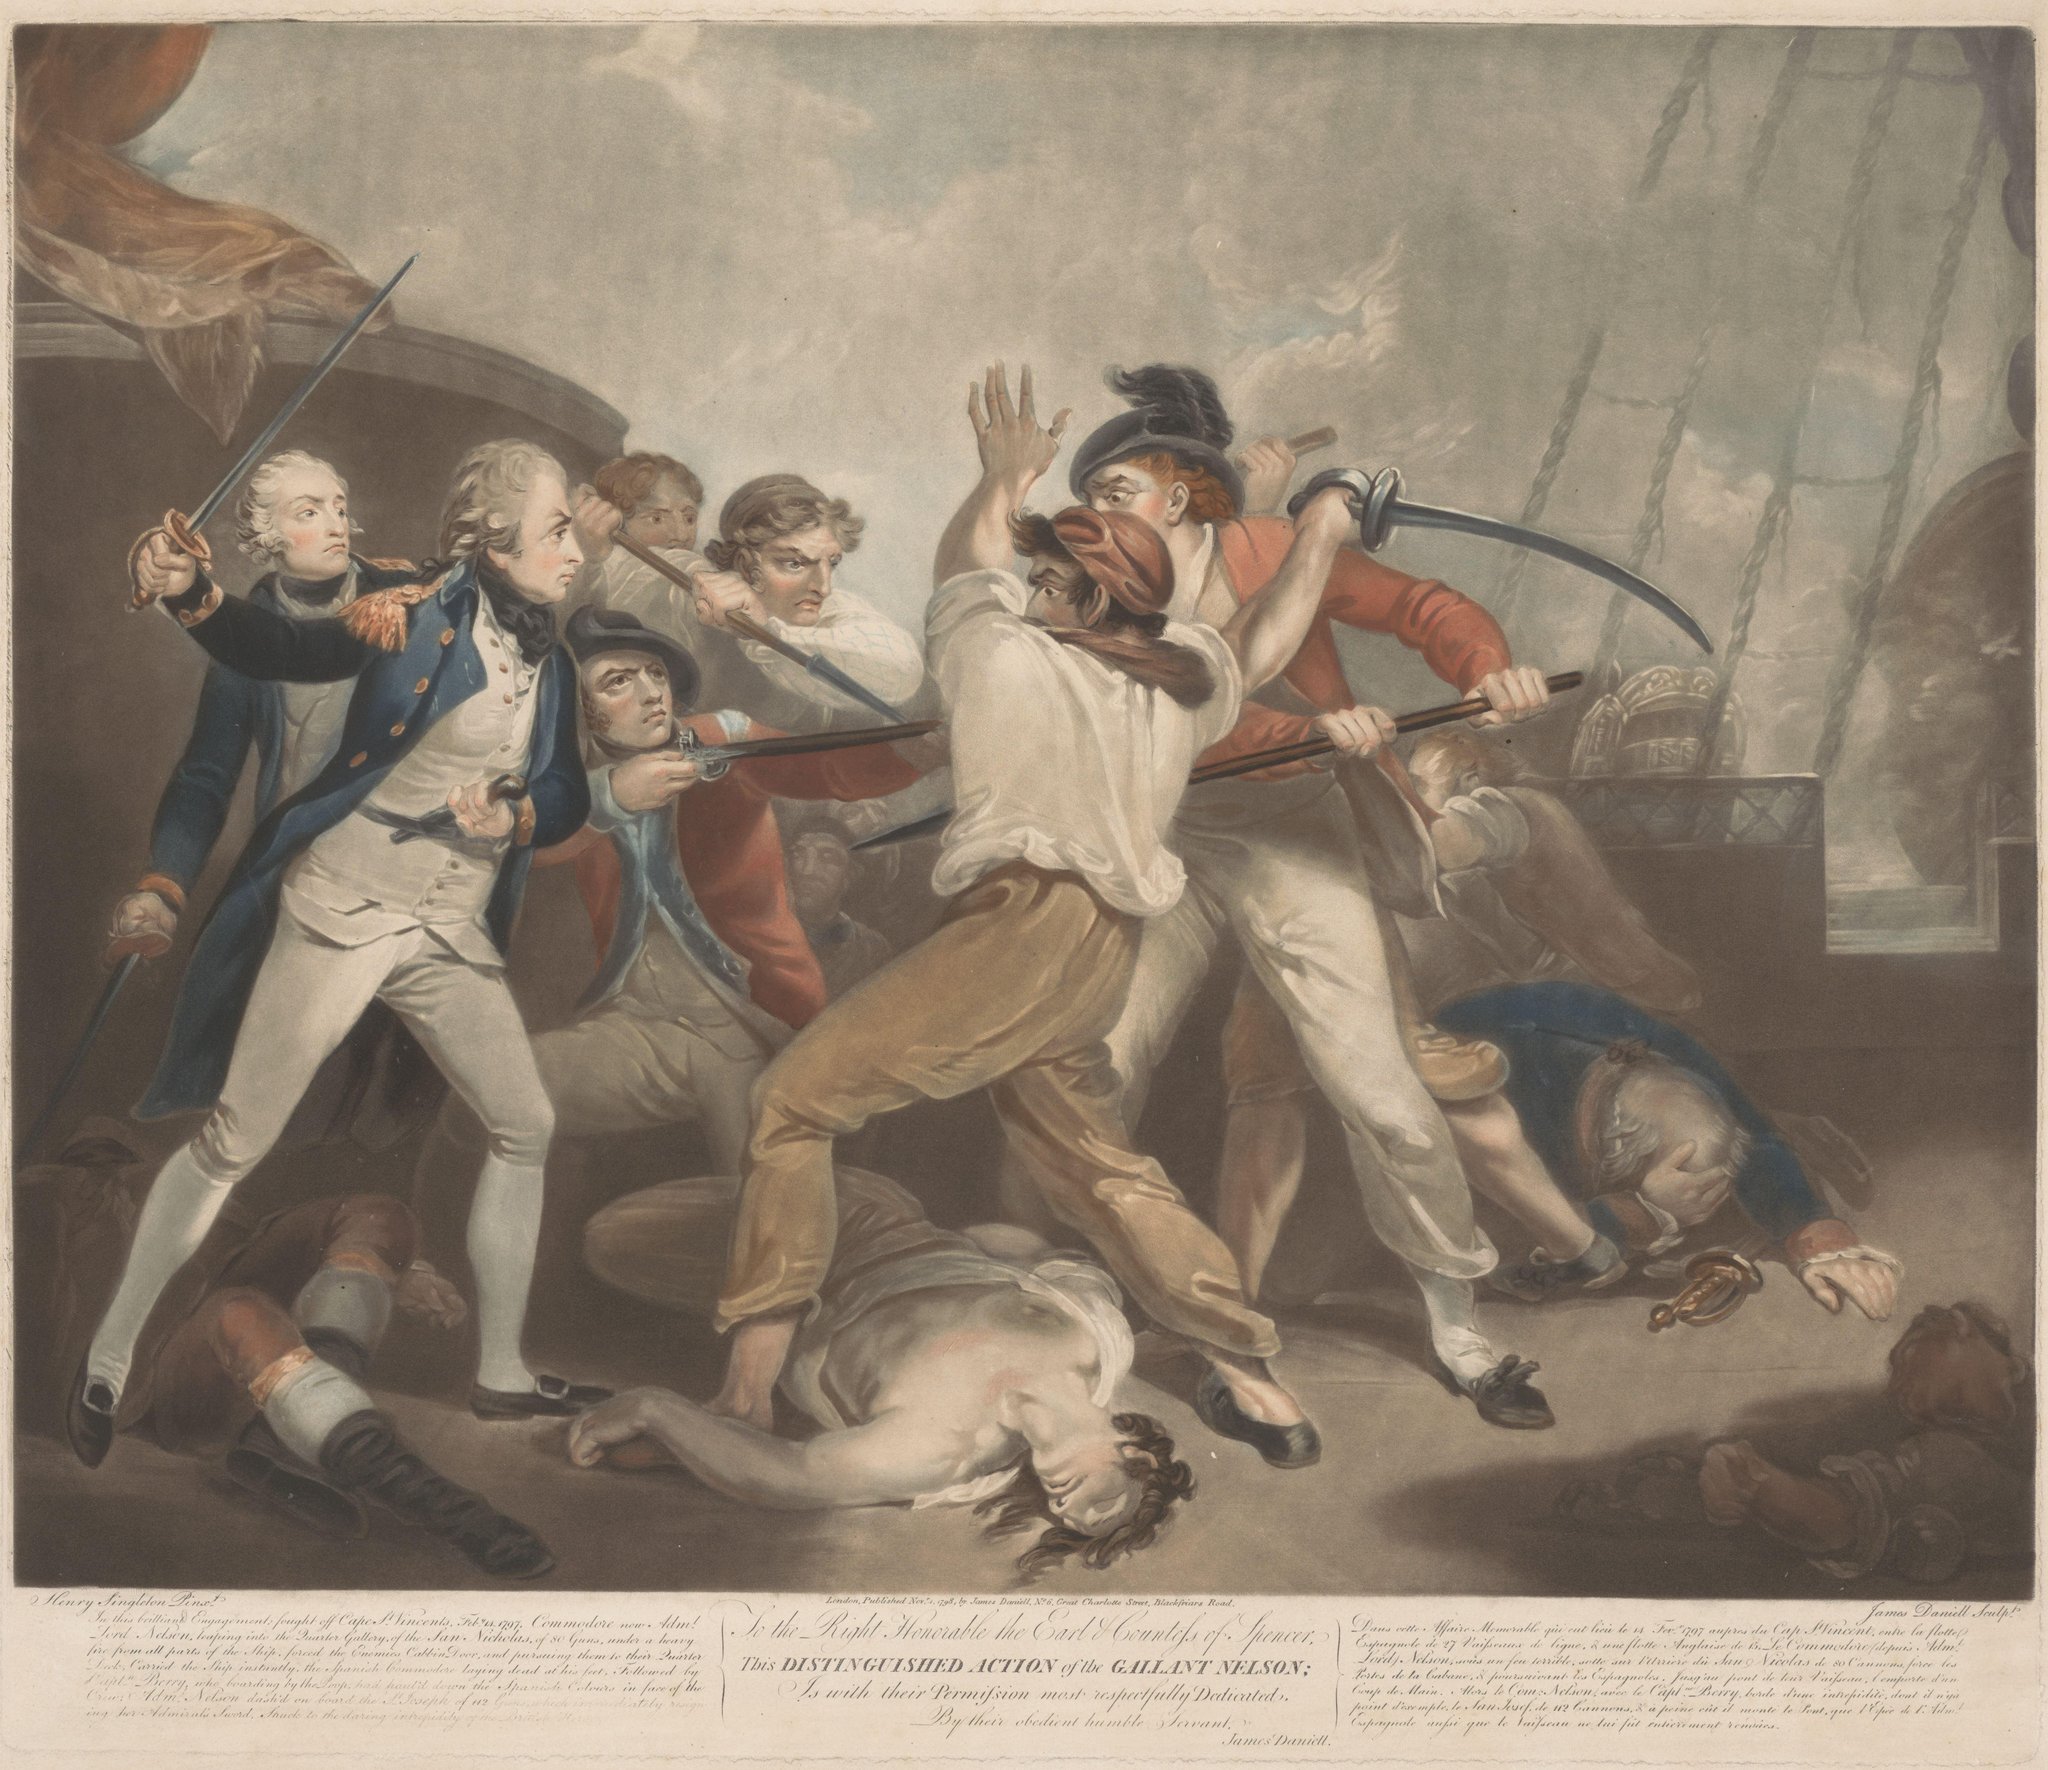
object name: print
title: Horatio Nelson verslaat de Fransen bij Kaap Sint-Vincent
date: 1711-1798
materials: paper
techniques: engraving, hand coloring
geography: london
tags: horatio nelson (hertog van bronte), historical persons, hand-to-hand fighting (~ battle), anonymous historical persons portrayed in a group, in a group-portrait, battle of cape st. vincent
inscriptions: collector's mark: Lugt 2228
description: Met Engels onderschrift verdeeld in drie blokken.